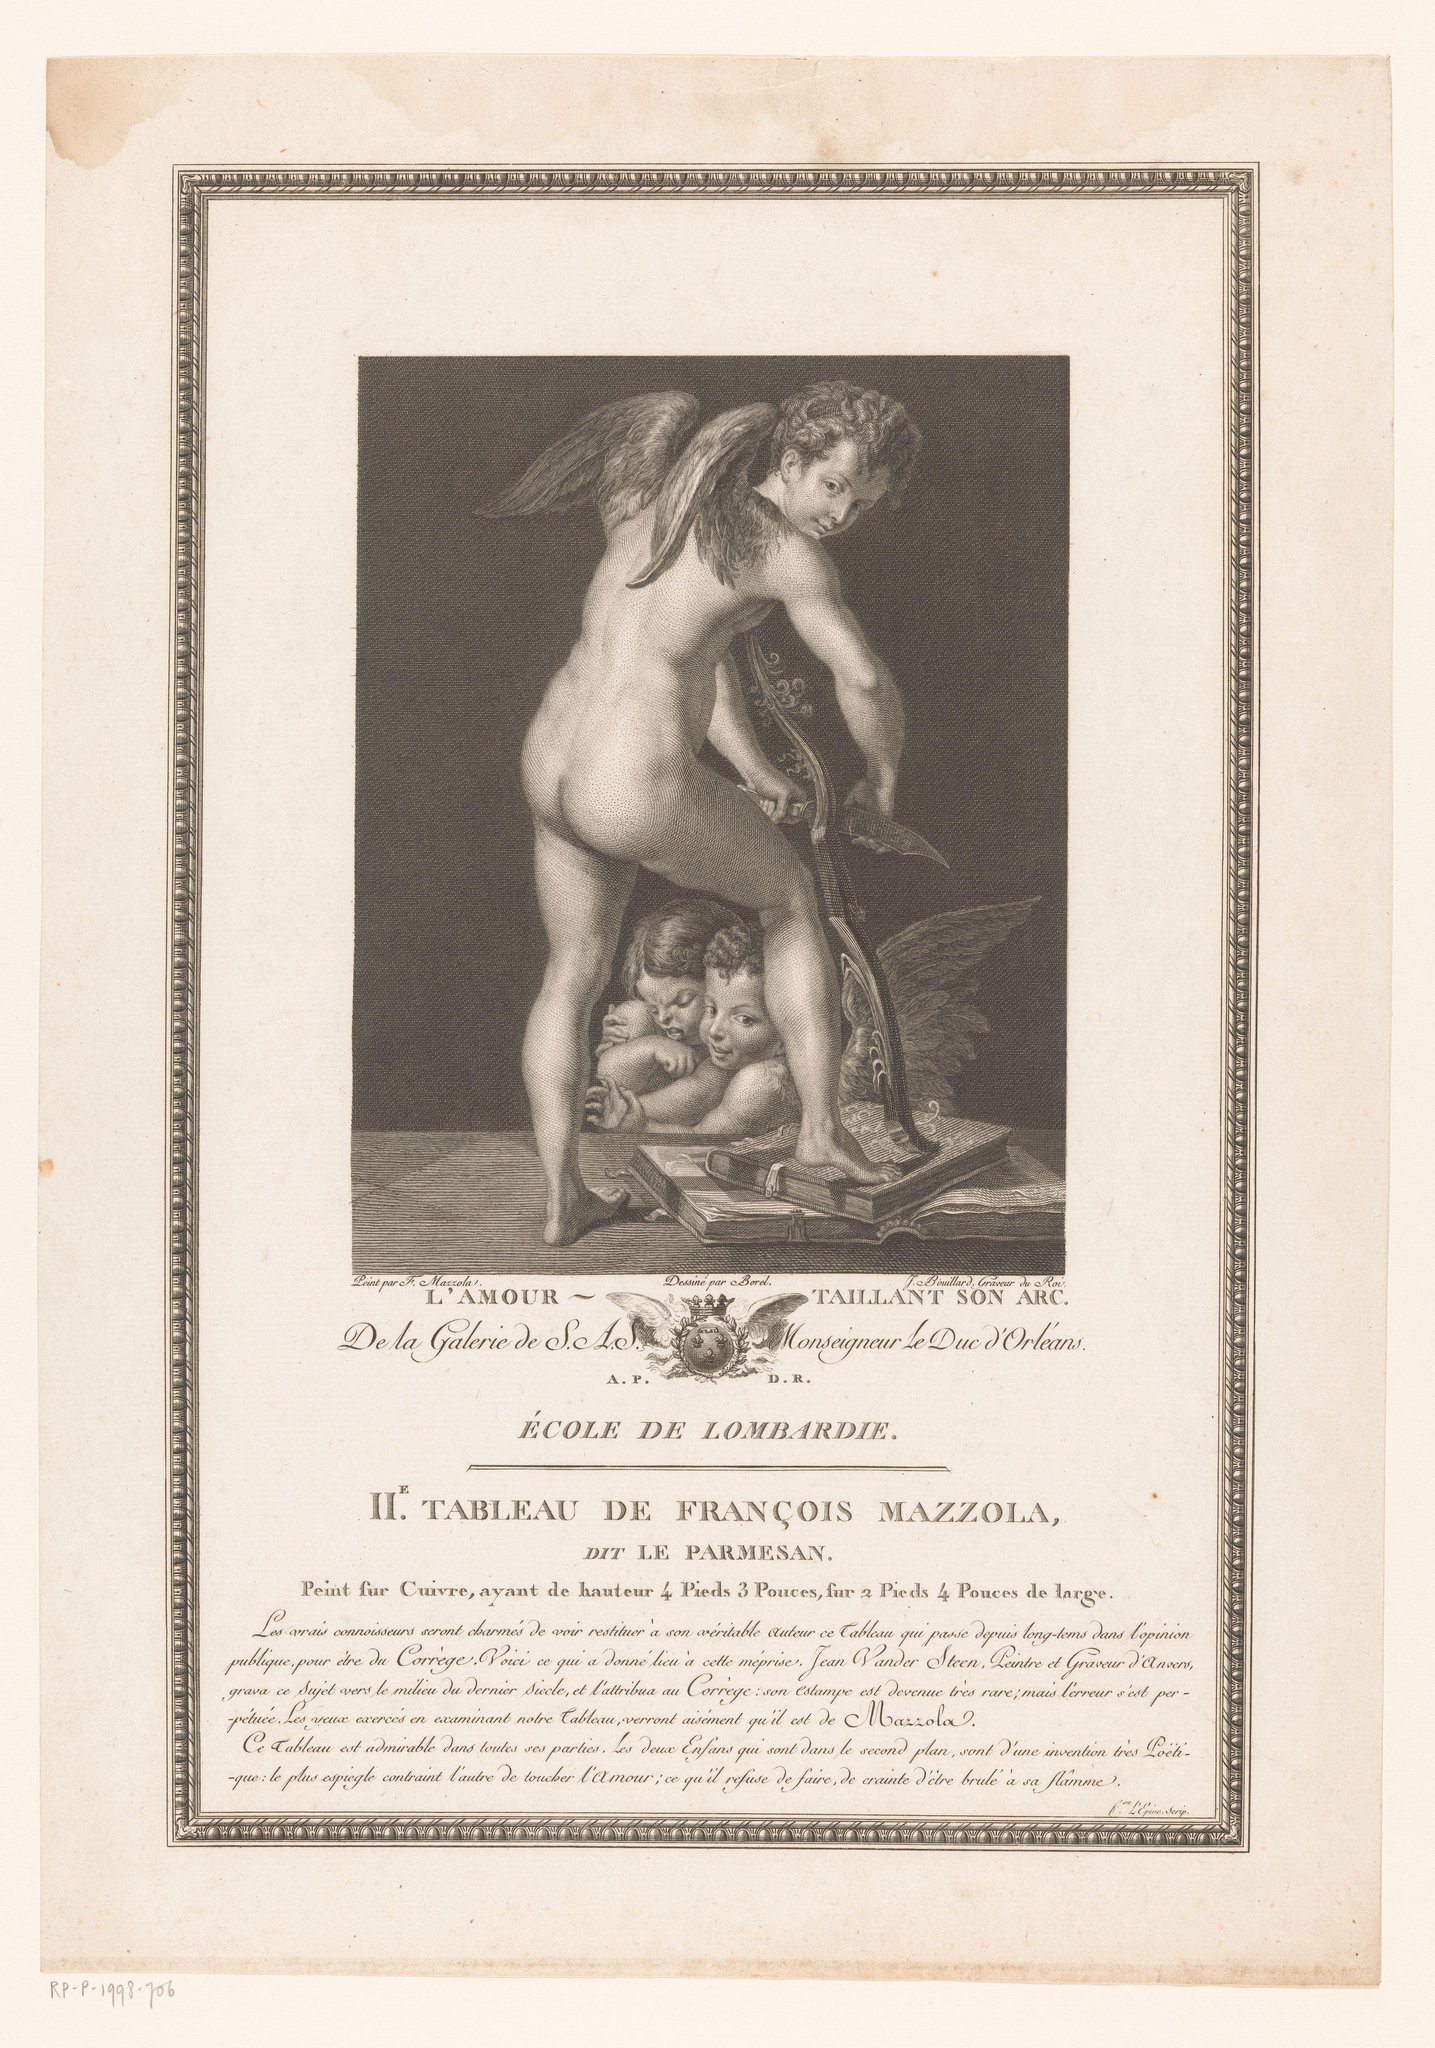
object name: print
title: La Galerie du Palais Royal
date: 1789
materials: paper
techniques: engraving, etching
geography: paris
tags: cupid handling his weapons, armorial bearing, heraldry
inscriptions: collector's mark: Lugt 2228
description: Onderdeel van een serie van 354 prenten naar schilderijen uit de collectie van de Hertog van Orléans, getiteld: La Galerie du Palais Royal, uitgebracht tussen 1786 en 1808. De serie werd uitgegeven door Jacques Couché die het project samen met Jacques Bouillard leidde.